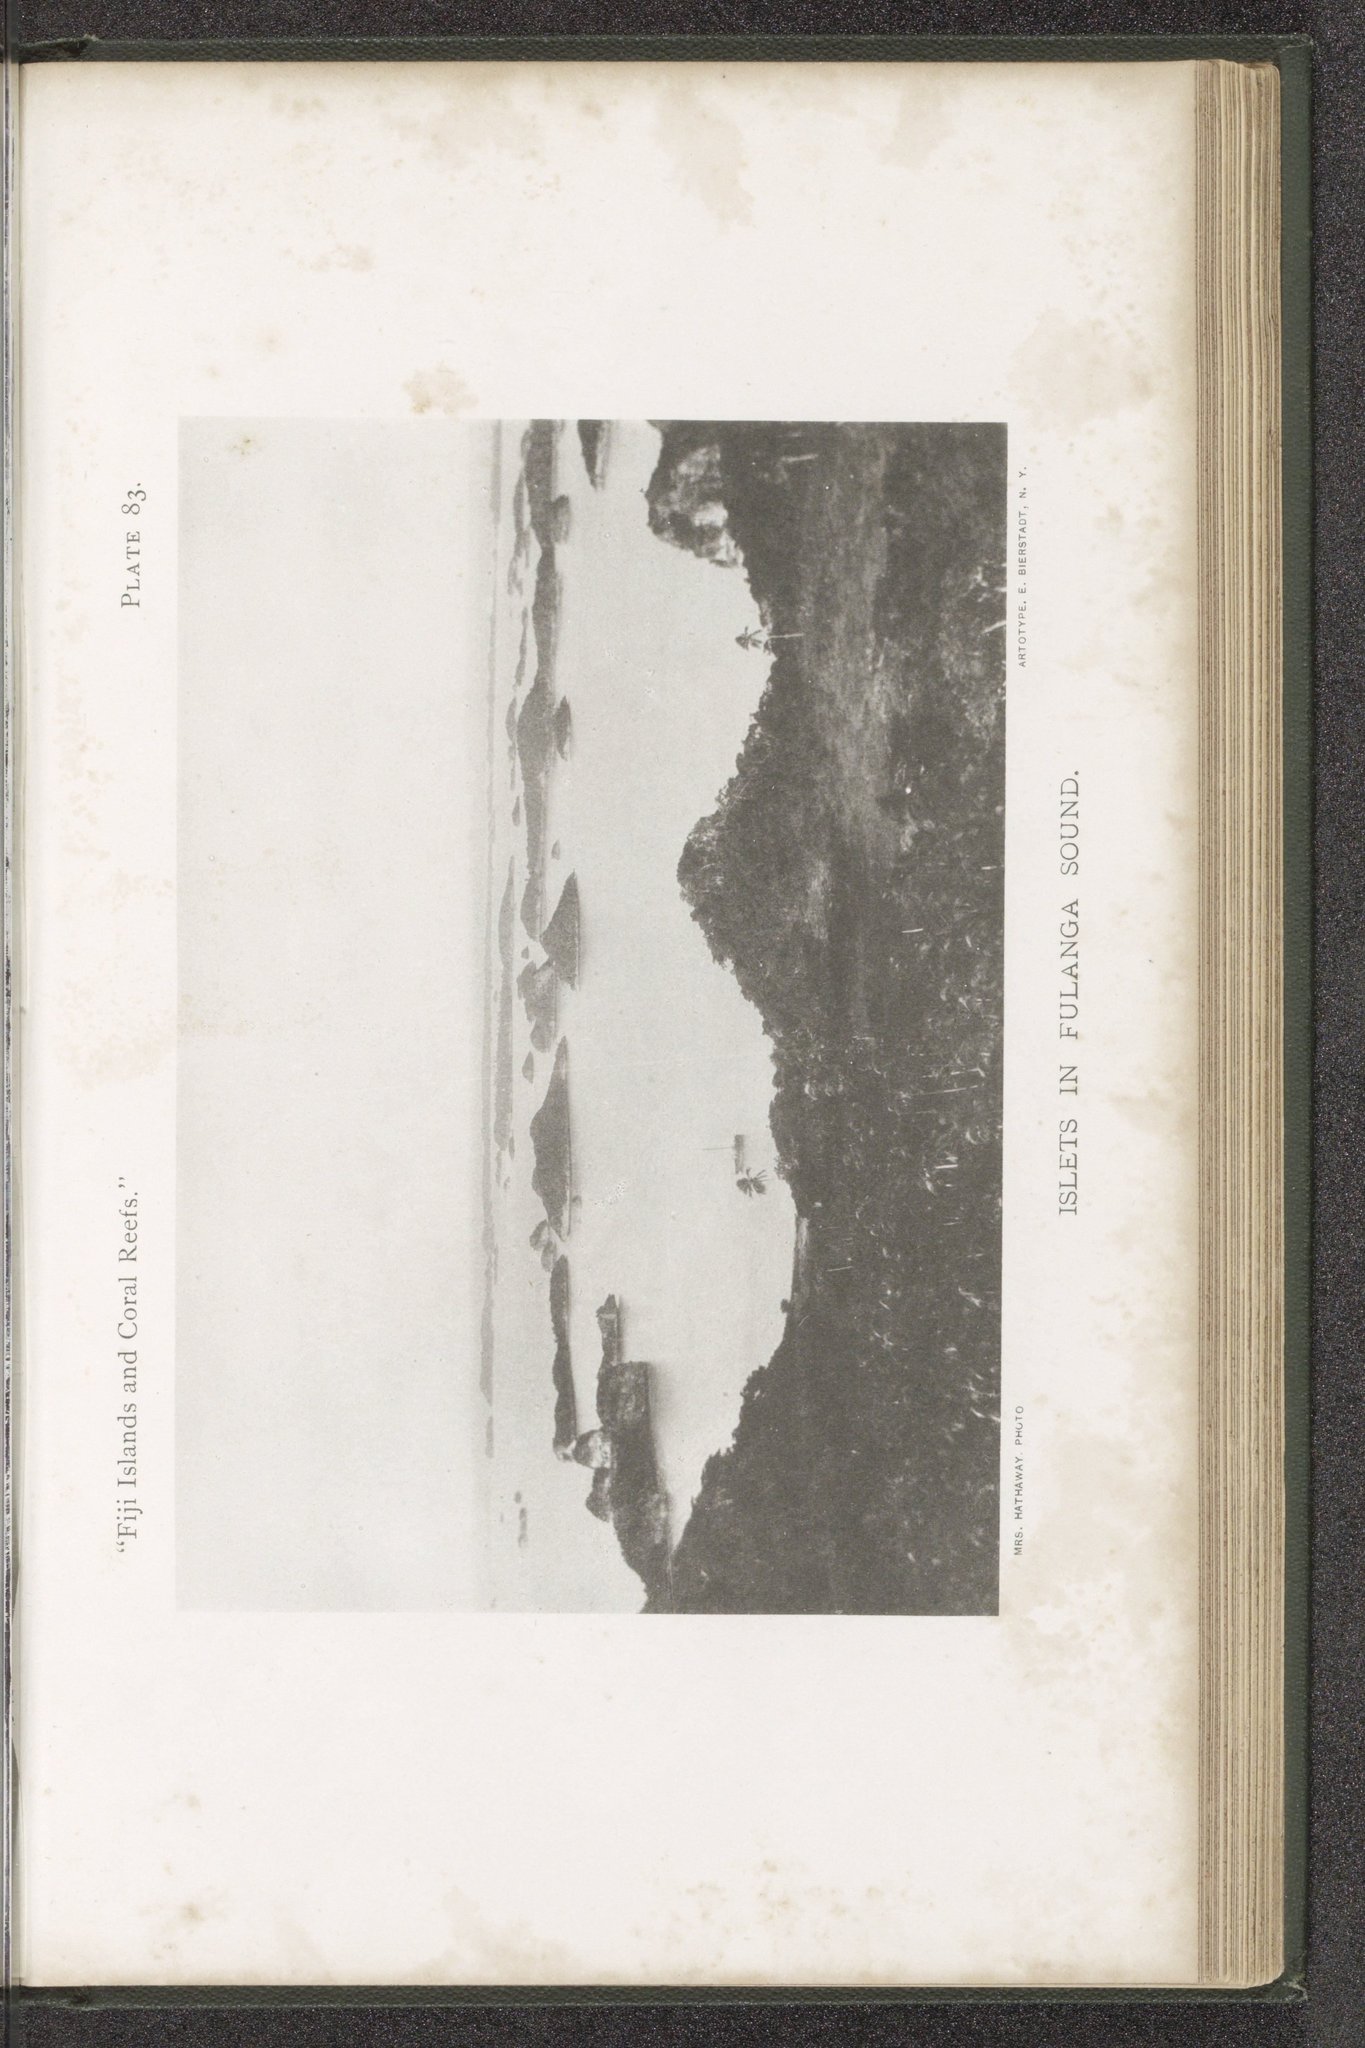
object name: photomechanical print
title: Islets in Fulanga sound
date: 1885-1899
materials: paper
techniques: photograph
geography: new york city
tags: island, ocean, haff, lagoon created by sand, shingle bank ~ coast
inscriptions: name: ‘Mrs. Hathaway, Photo.’, number: ‘Plate 83.’, name: ‘Artotype. E. Bierstadt, N. Y.’